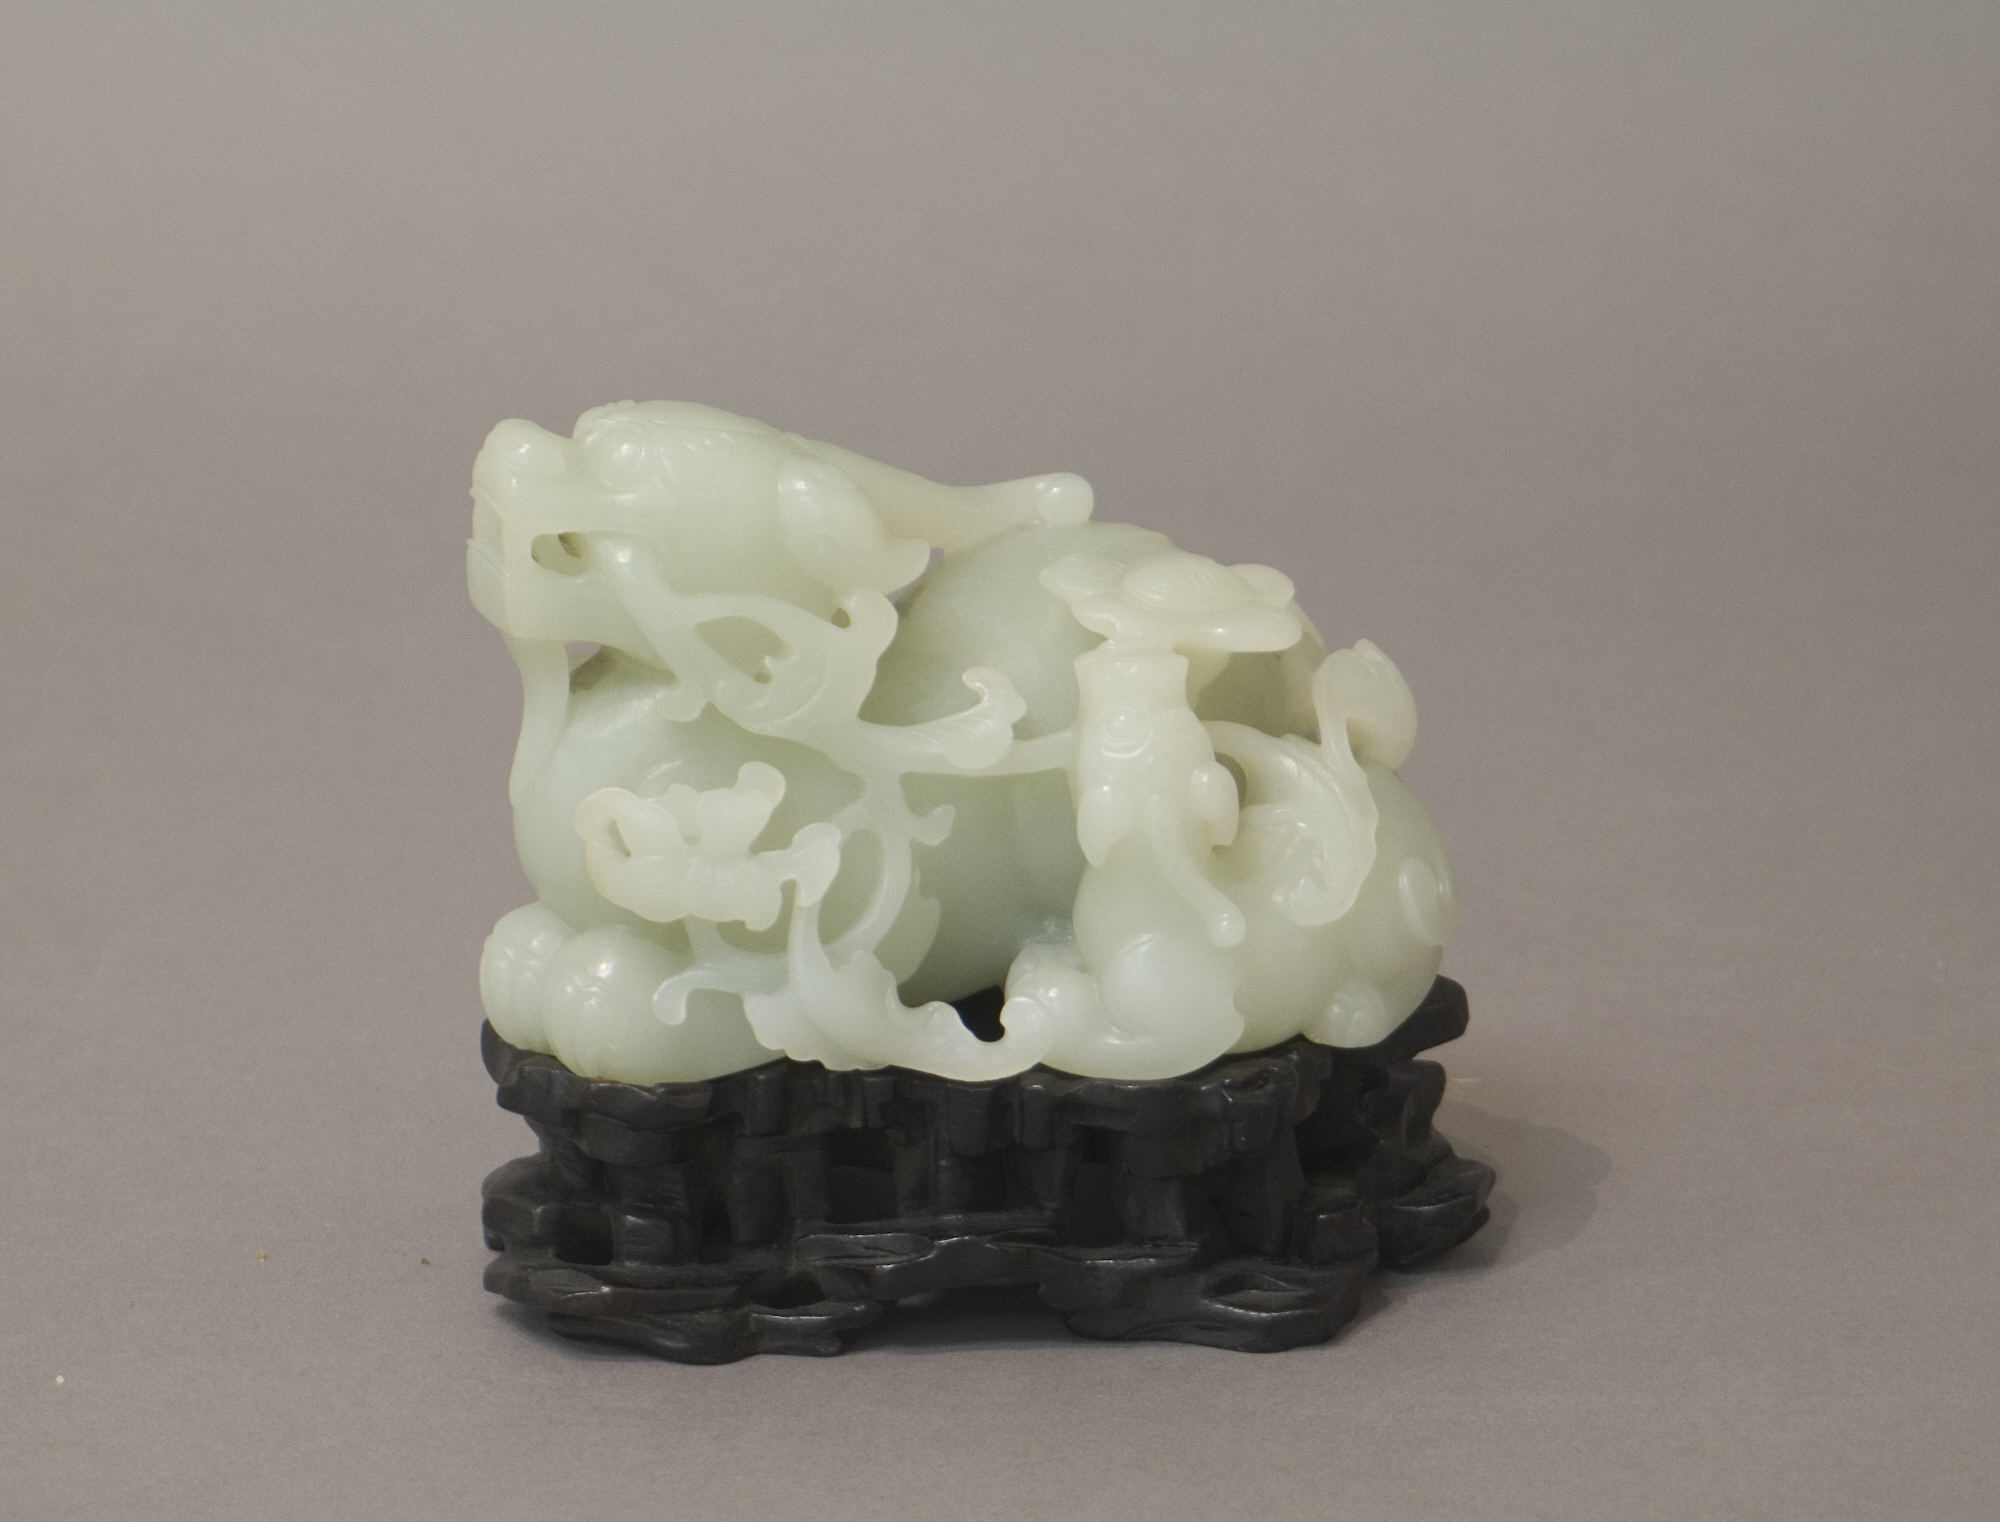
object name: figurine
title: Fantastic animal and cub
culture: chinese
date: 1701-1900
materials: jade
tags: animals